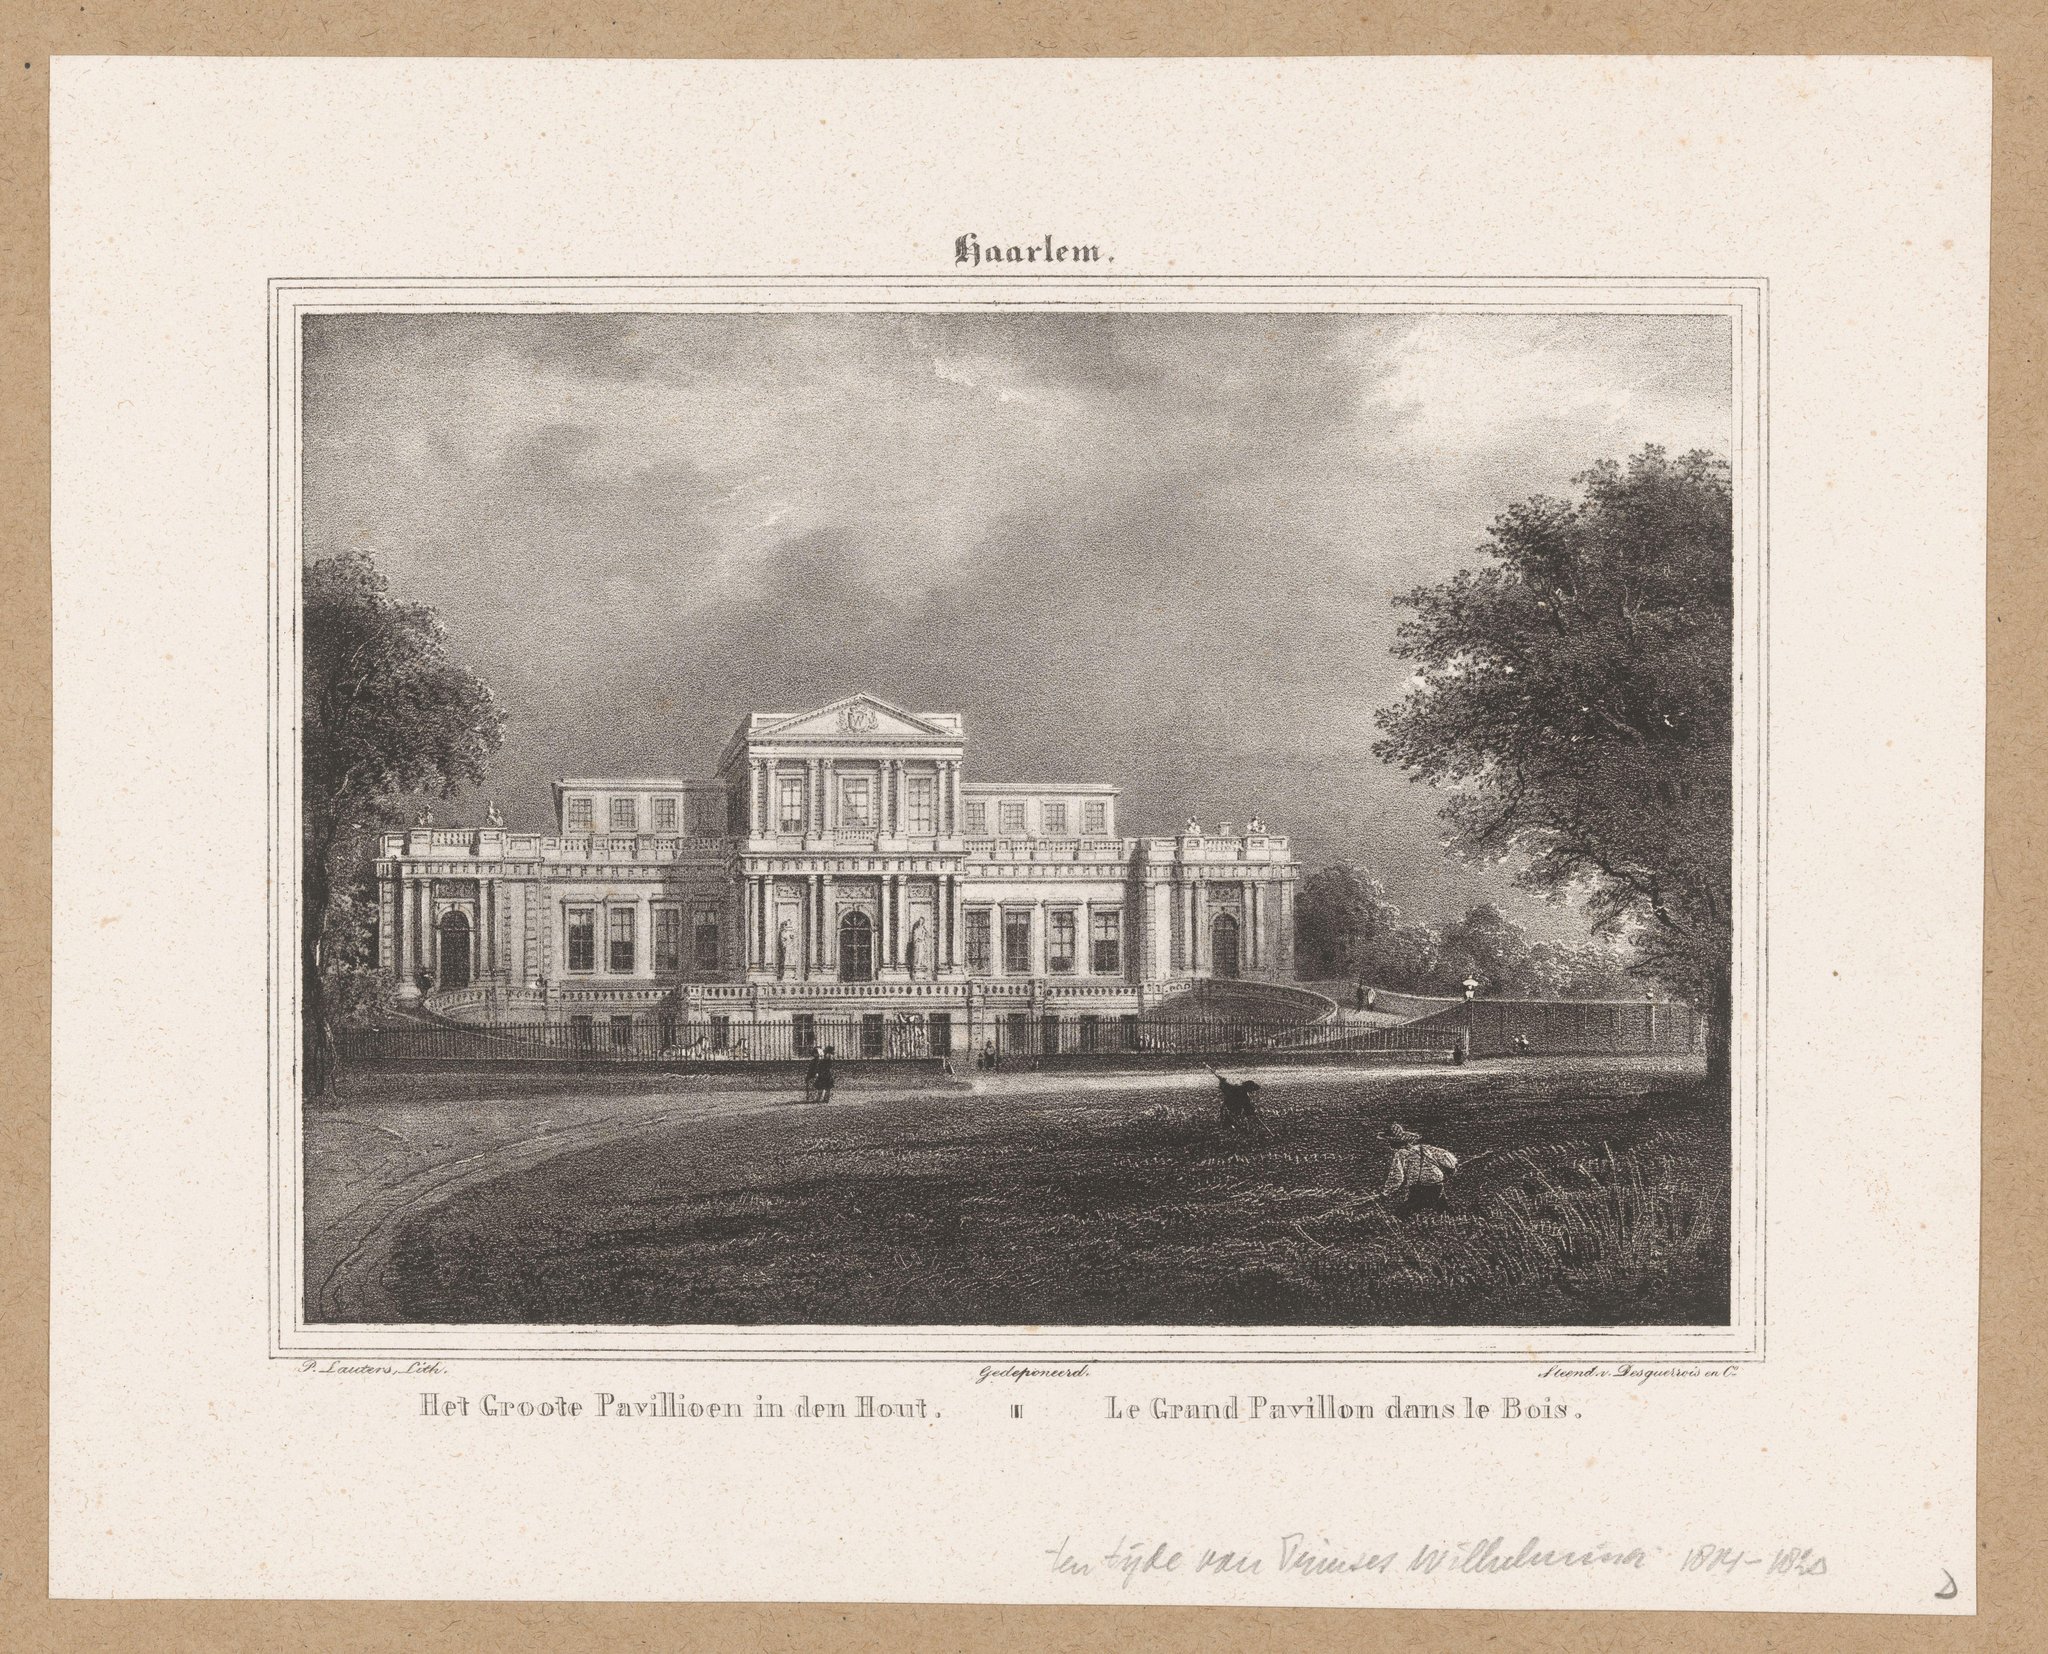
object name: print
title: Gezicht op Paviljoen Welgelegen in de Haarlemmerhout in Haarlem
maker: paulus lauters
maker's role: print maker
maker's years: 1806-1875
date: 1827-1900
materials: paper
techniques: lithograph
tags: edifice, e.g.: public building, department store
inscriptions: collector's mark: Lugt 2228